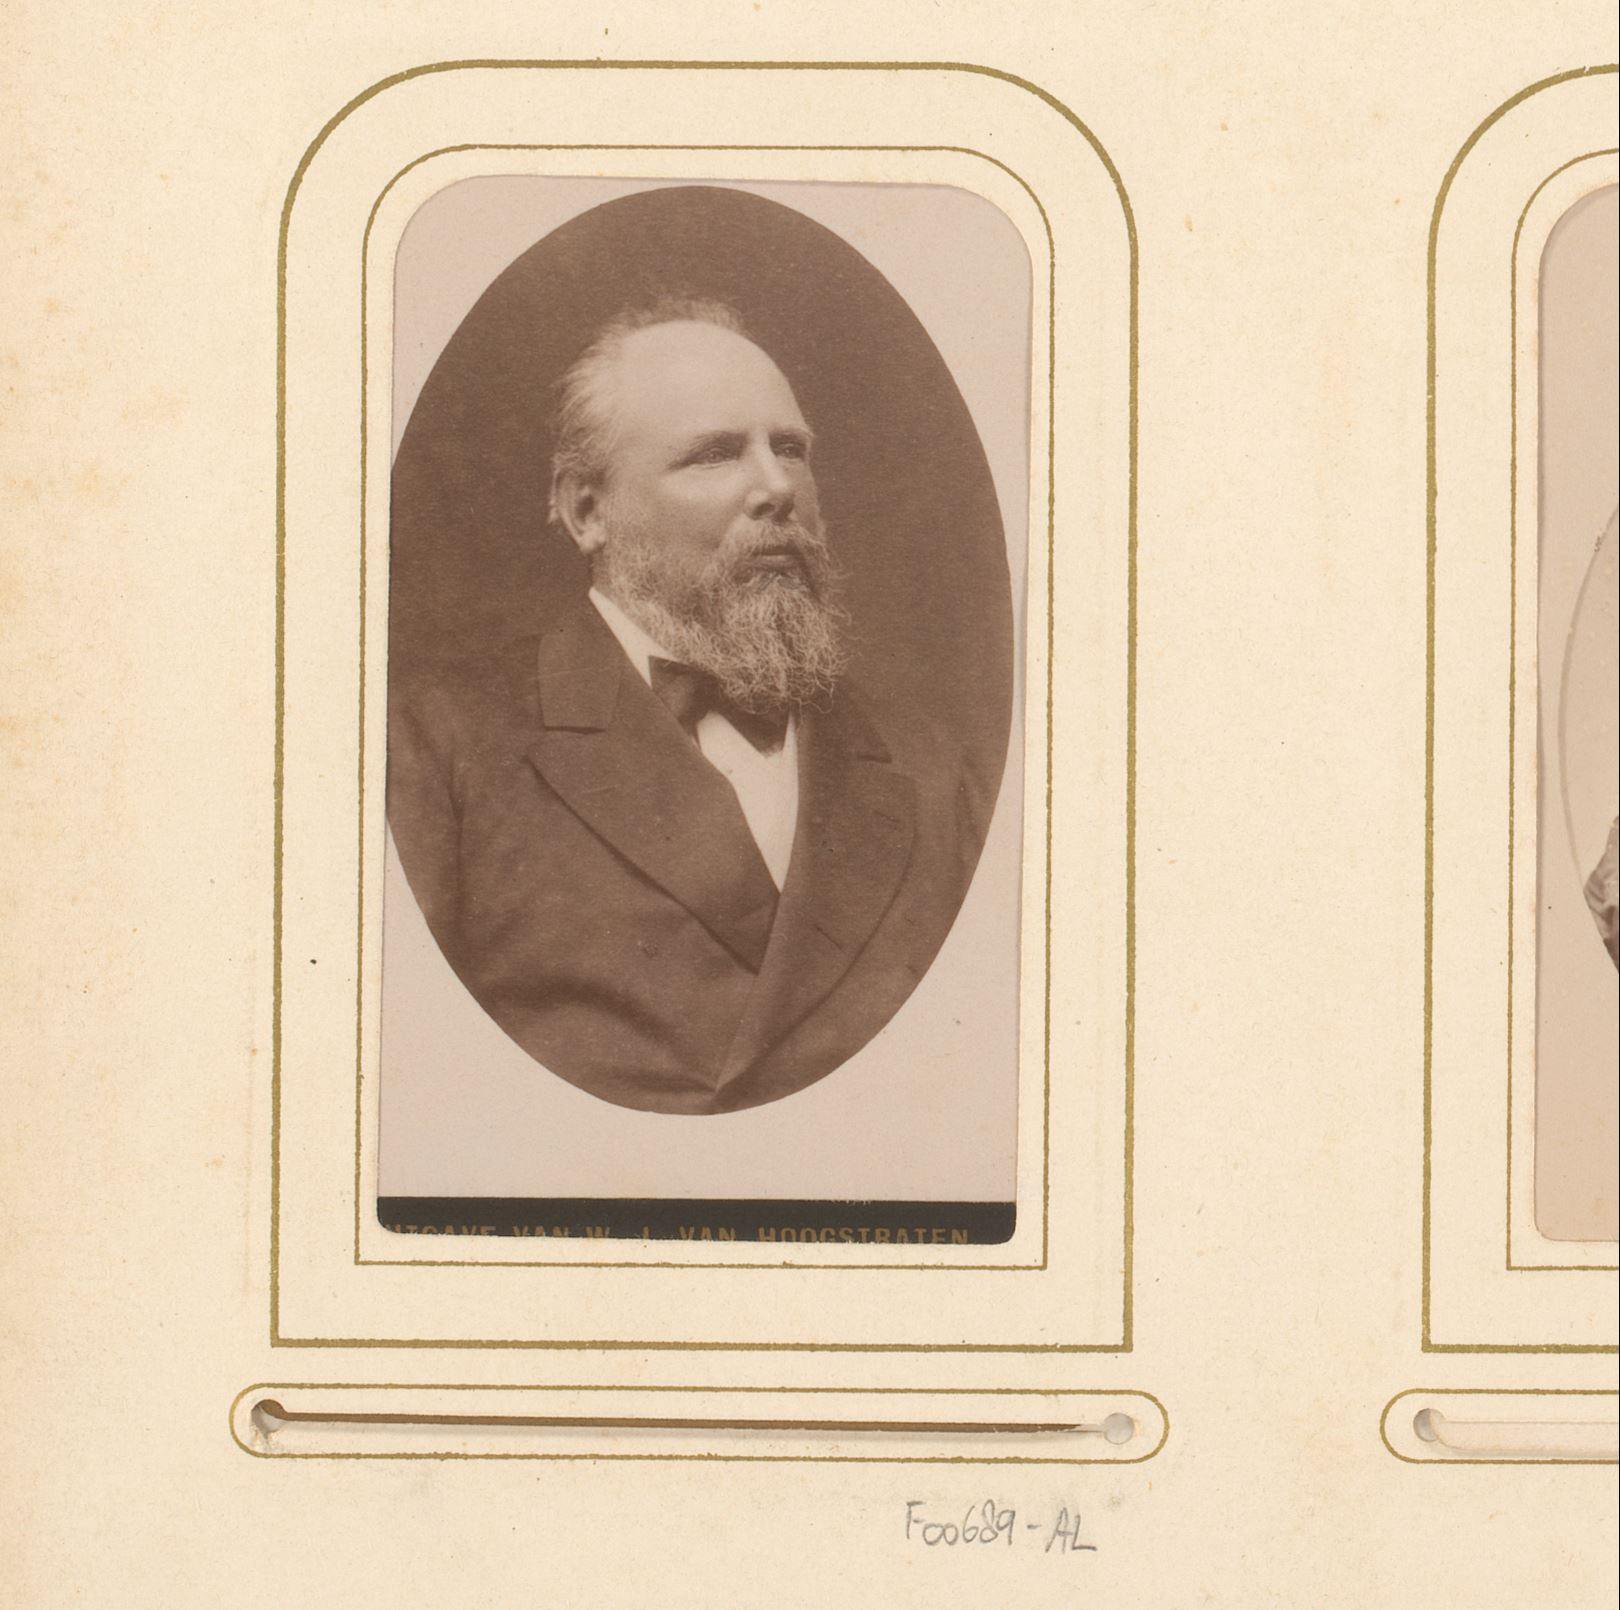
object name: album leaf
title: Portret van een man met baard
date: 1875-1910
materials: cardboard, photographic support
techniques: albumen print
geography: the hague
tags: historical persons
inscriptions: inscription: ‘H.W. Wollrabe (...) 96, Noordeinde 96/ 's Gravenhage’